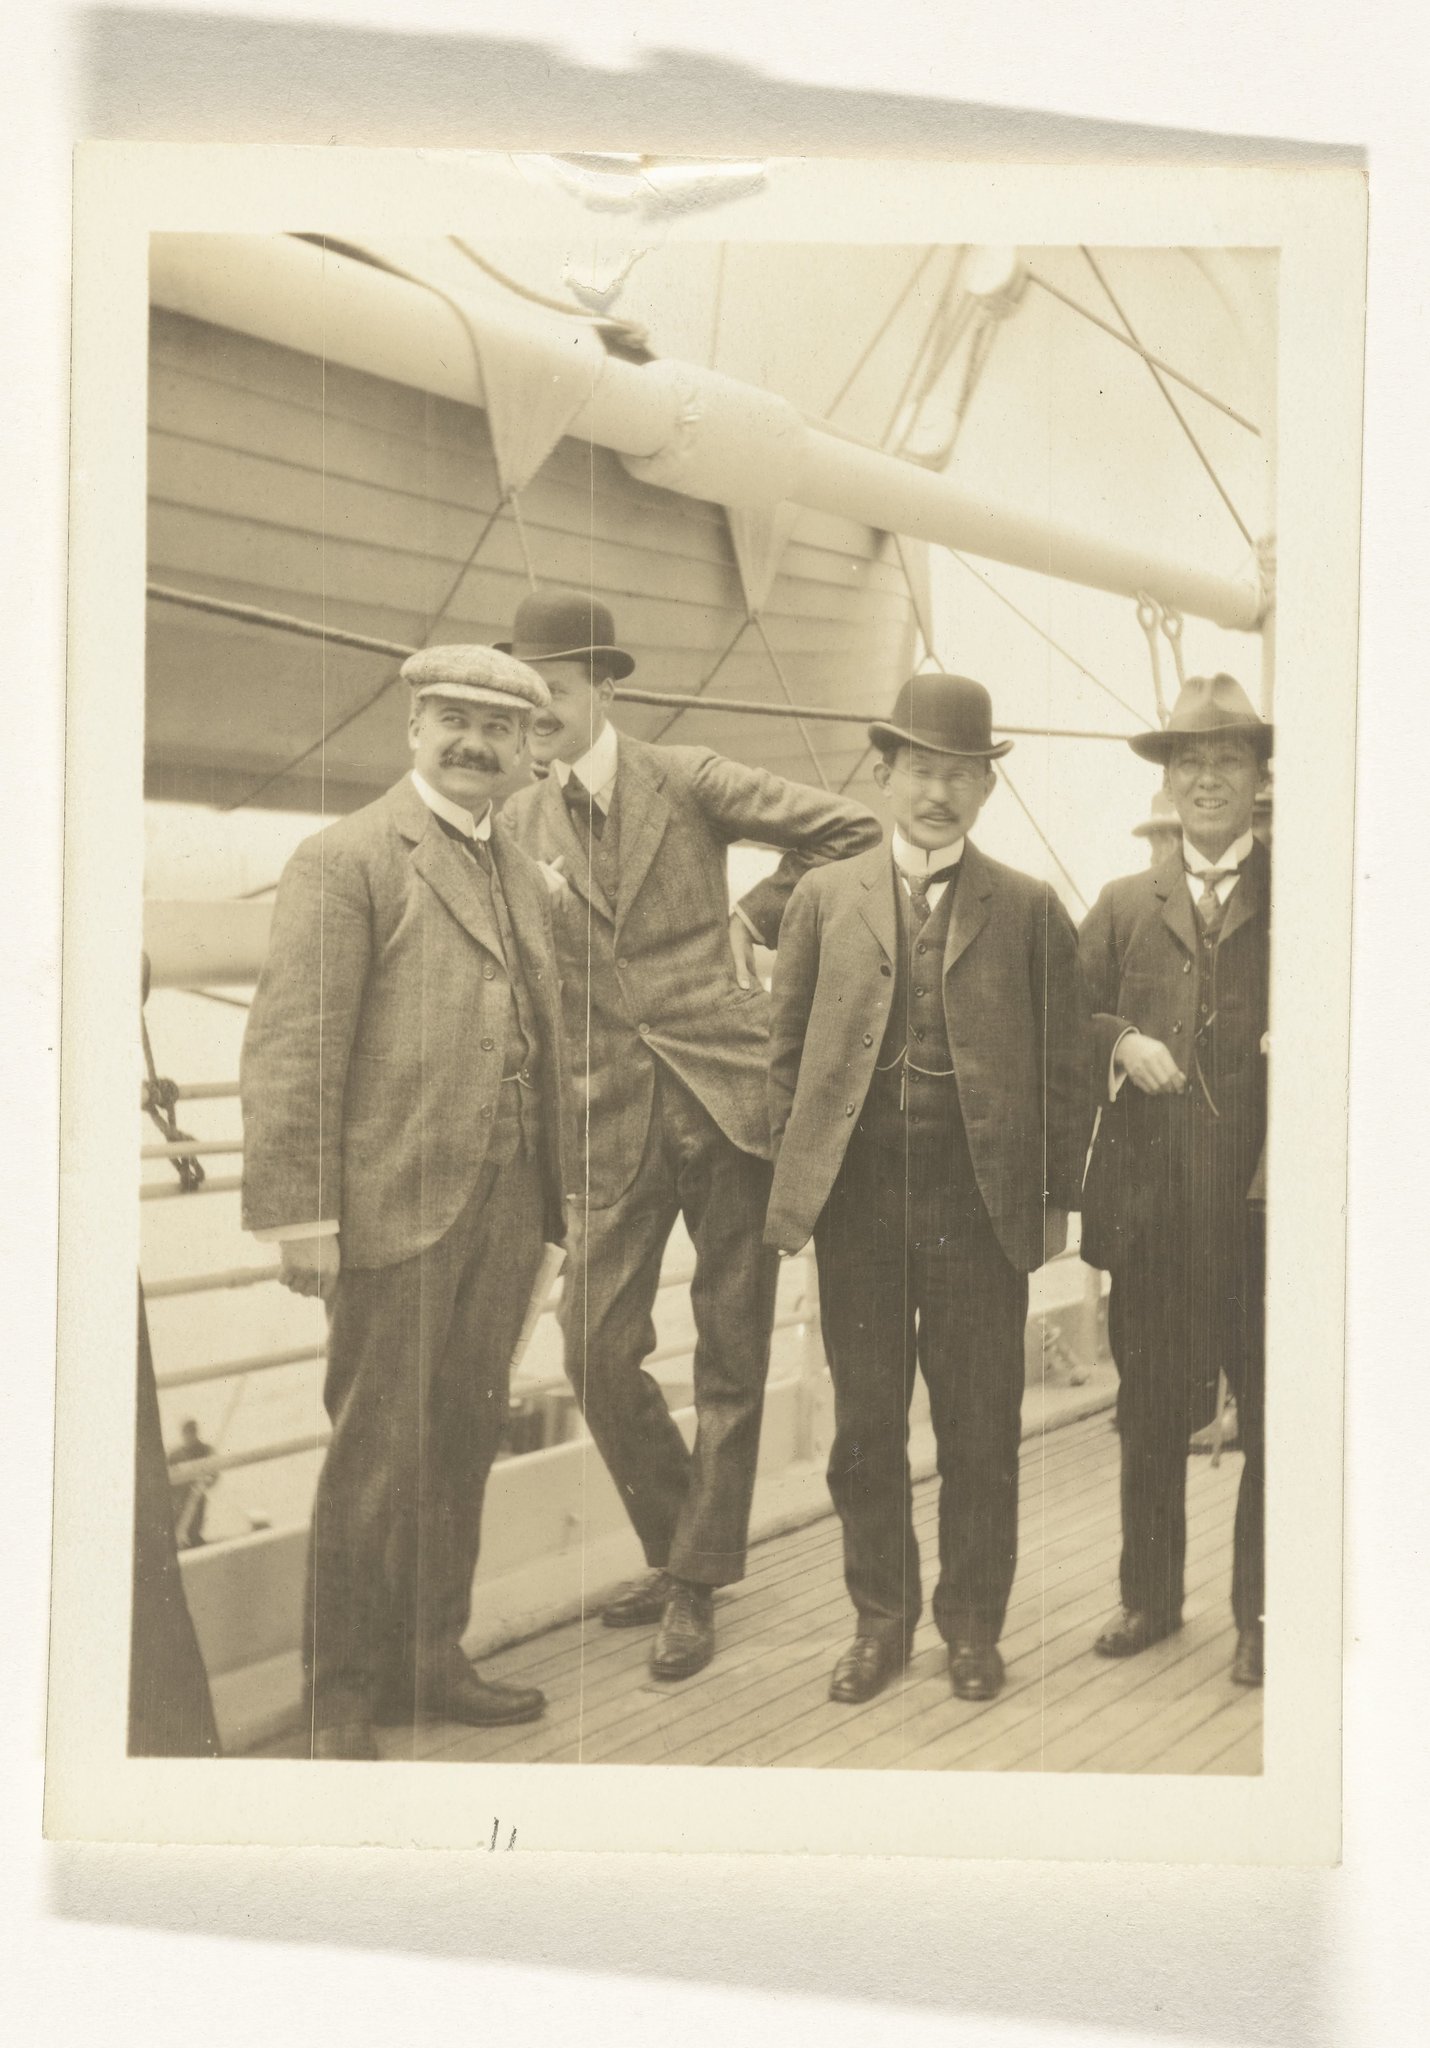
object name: photograph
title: The rising sun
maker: geldolph adriaan kessler (dolph)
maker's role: fotograaf, industrieel, voetballer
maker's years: 1884-1945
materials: cardboard, photographic support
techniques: gelatin silver print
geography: yokohama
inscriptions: title: ‘The Rising sun’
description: Reisgenoten van Dolph Kessler, waaronder links met witte pet Henri Deterding aan boord van The Empress of India, onderweg van Yokohama naar Vancouver. Onderdeel van het fotoalbum van Dolph Kessler met opnamen die hij maakte tijdens zijn verblijf in Engeland en op een wereldreis die hij als secretaris van Henri Deterding (directeur Koninklijke Olie) ondernam naar Nederlands-Indië, Japan, China en de Verenigde Staten, tussen 1906 en 1908.